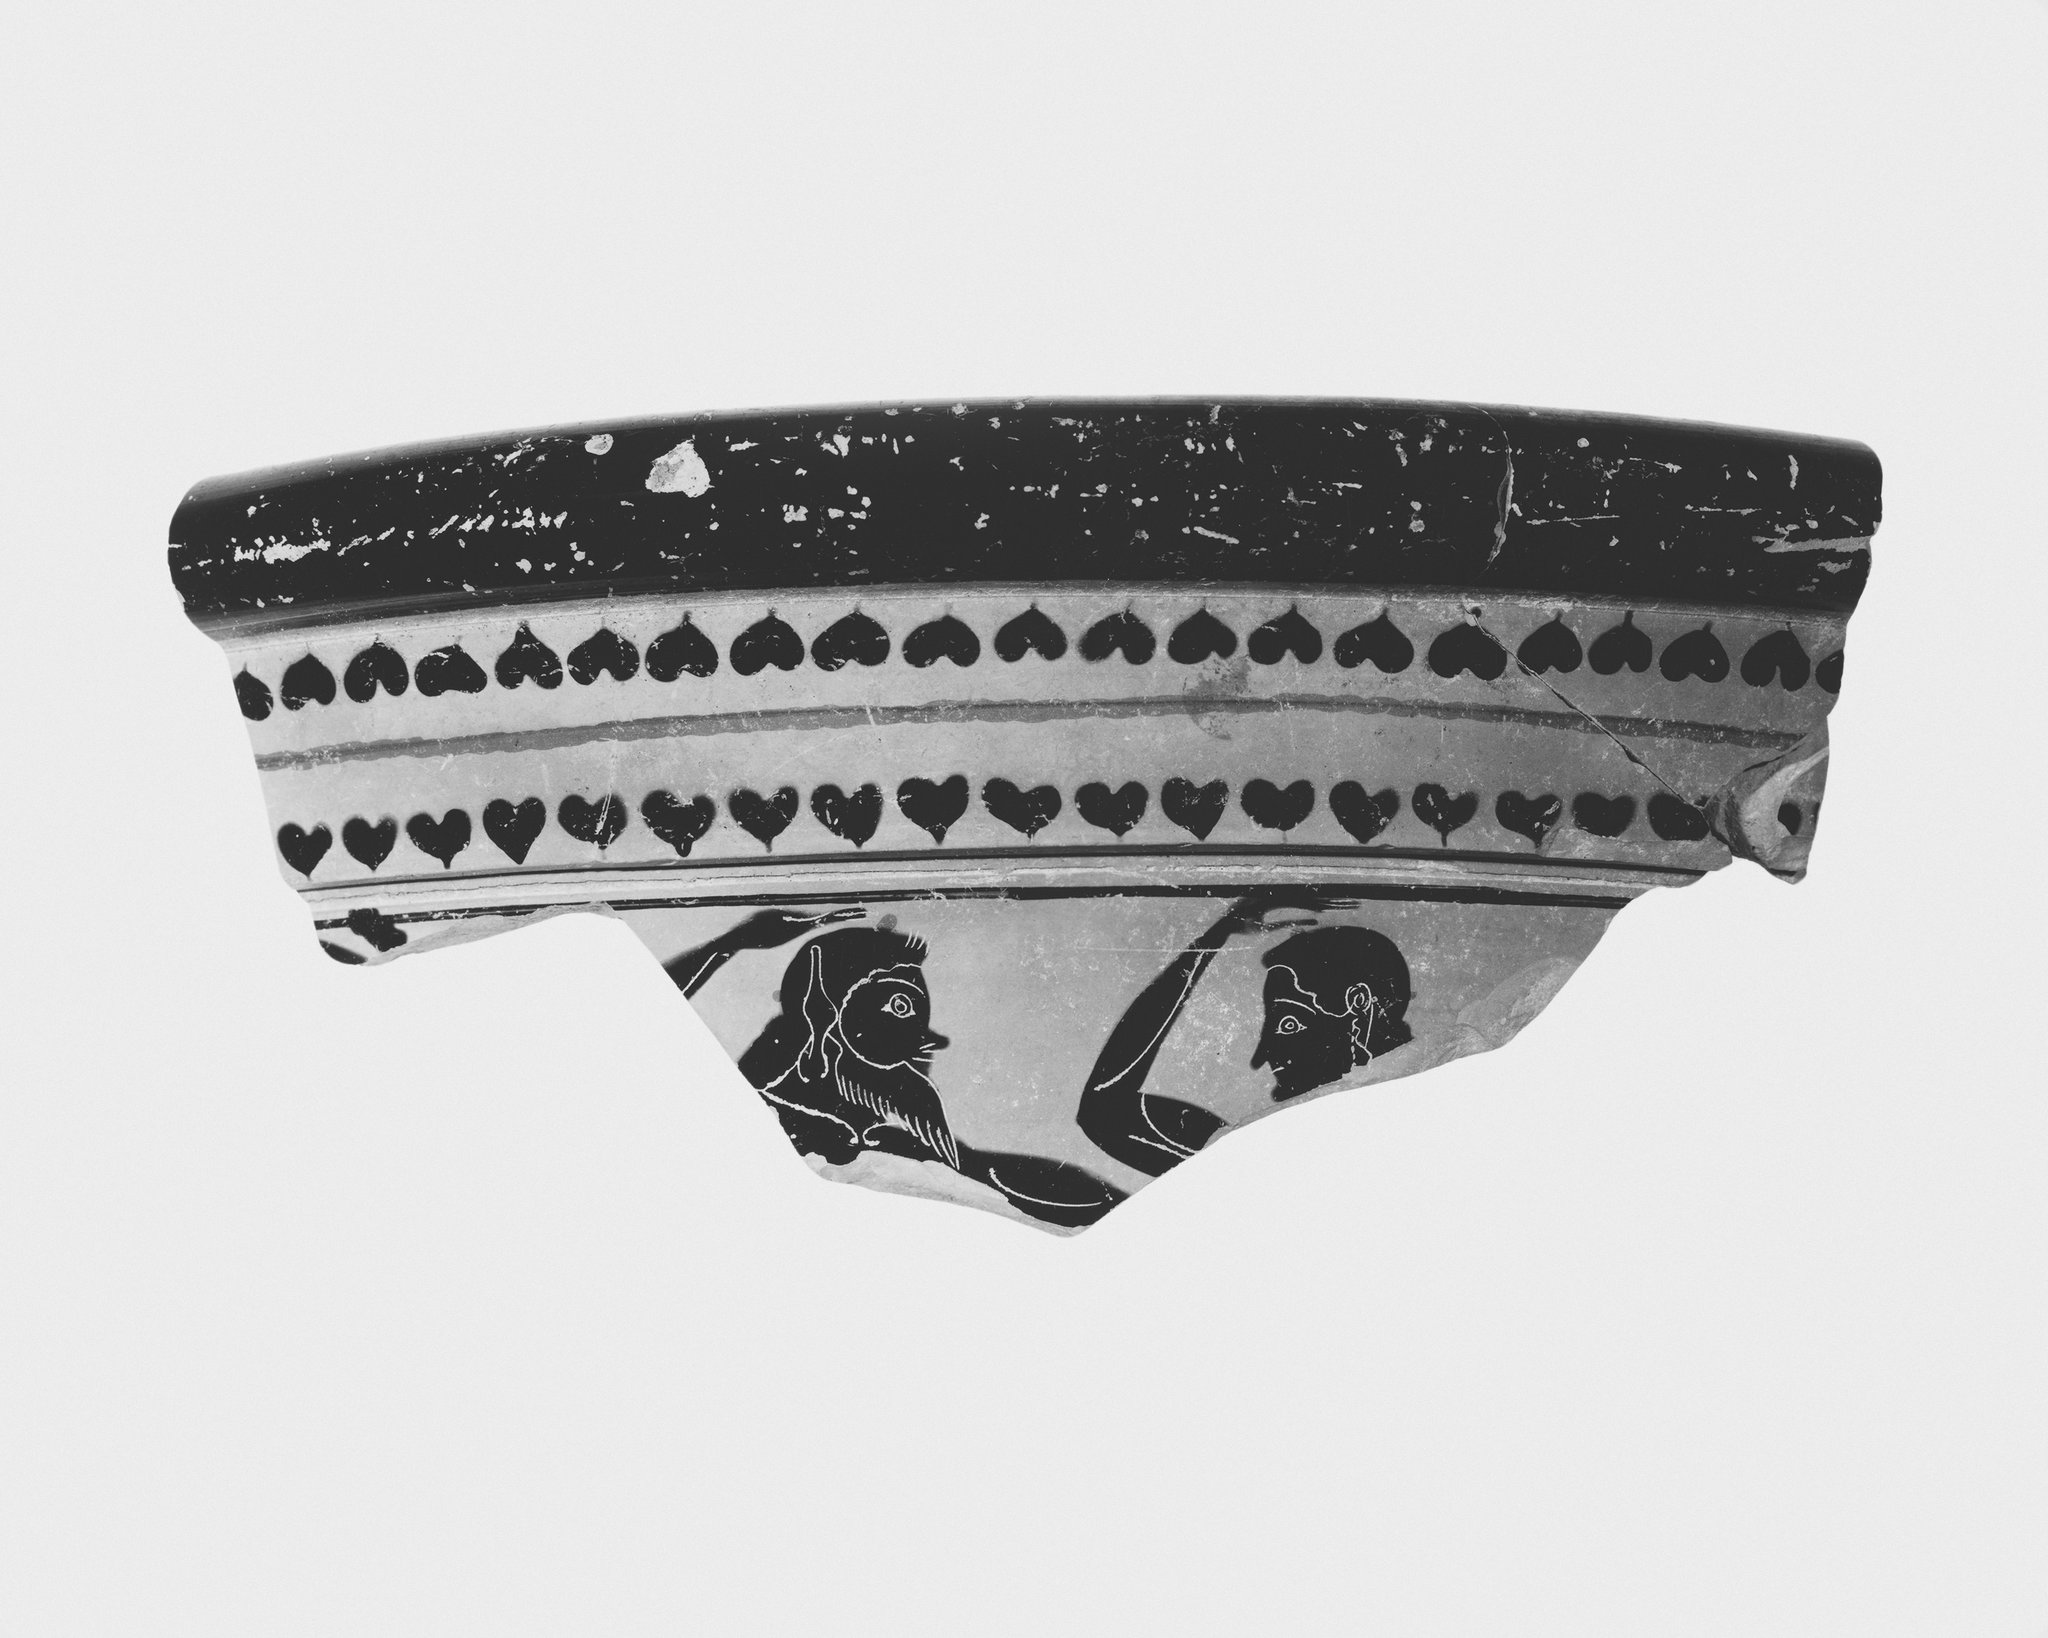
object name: calyx krater fragment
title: Calyx-krater, fragments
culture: greek, attic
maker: exekias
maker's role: artist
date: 540 BCE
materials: terracotta